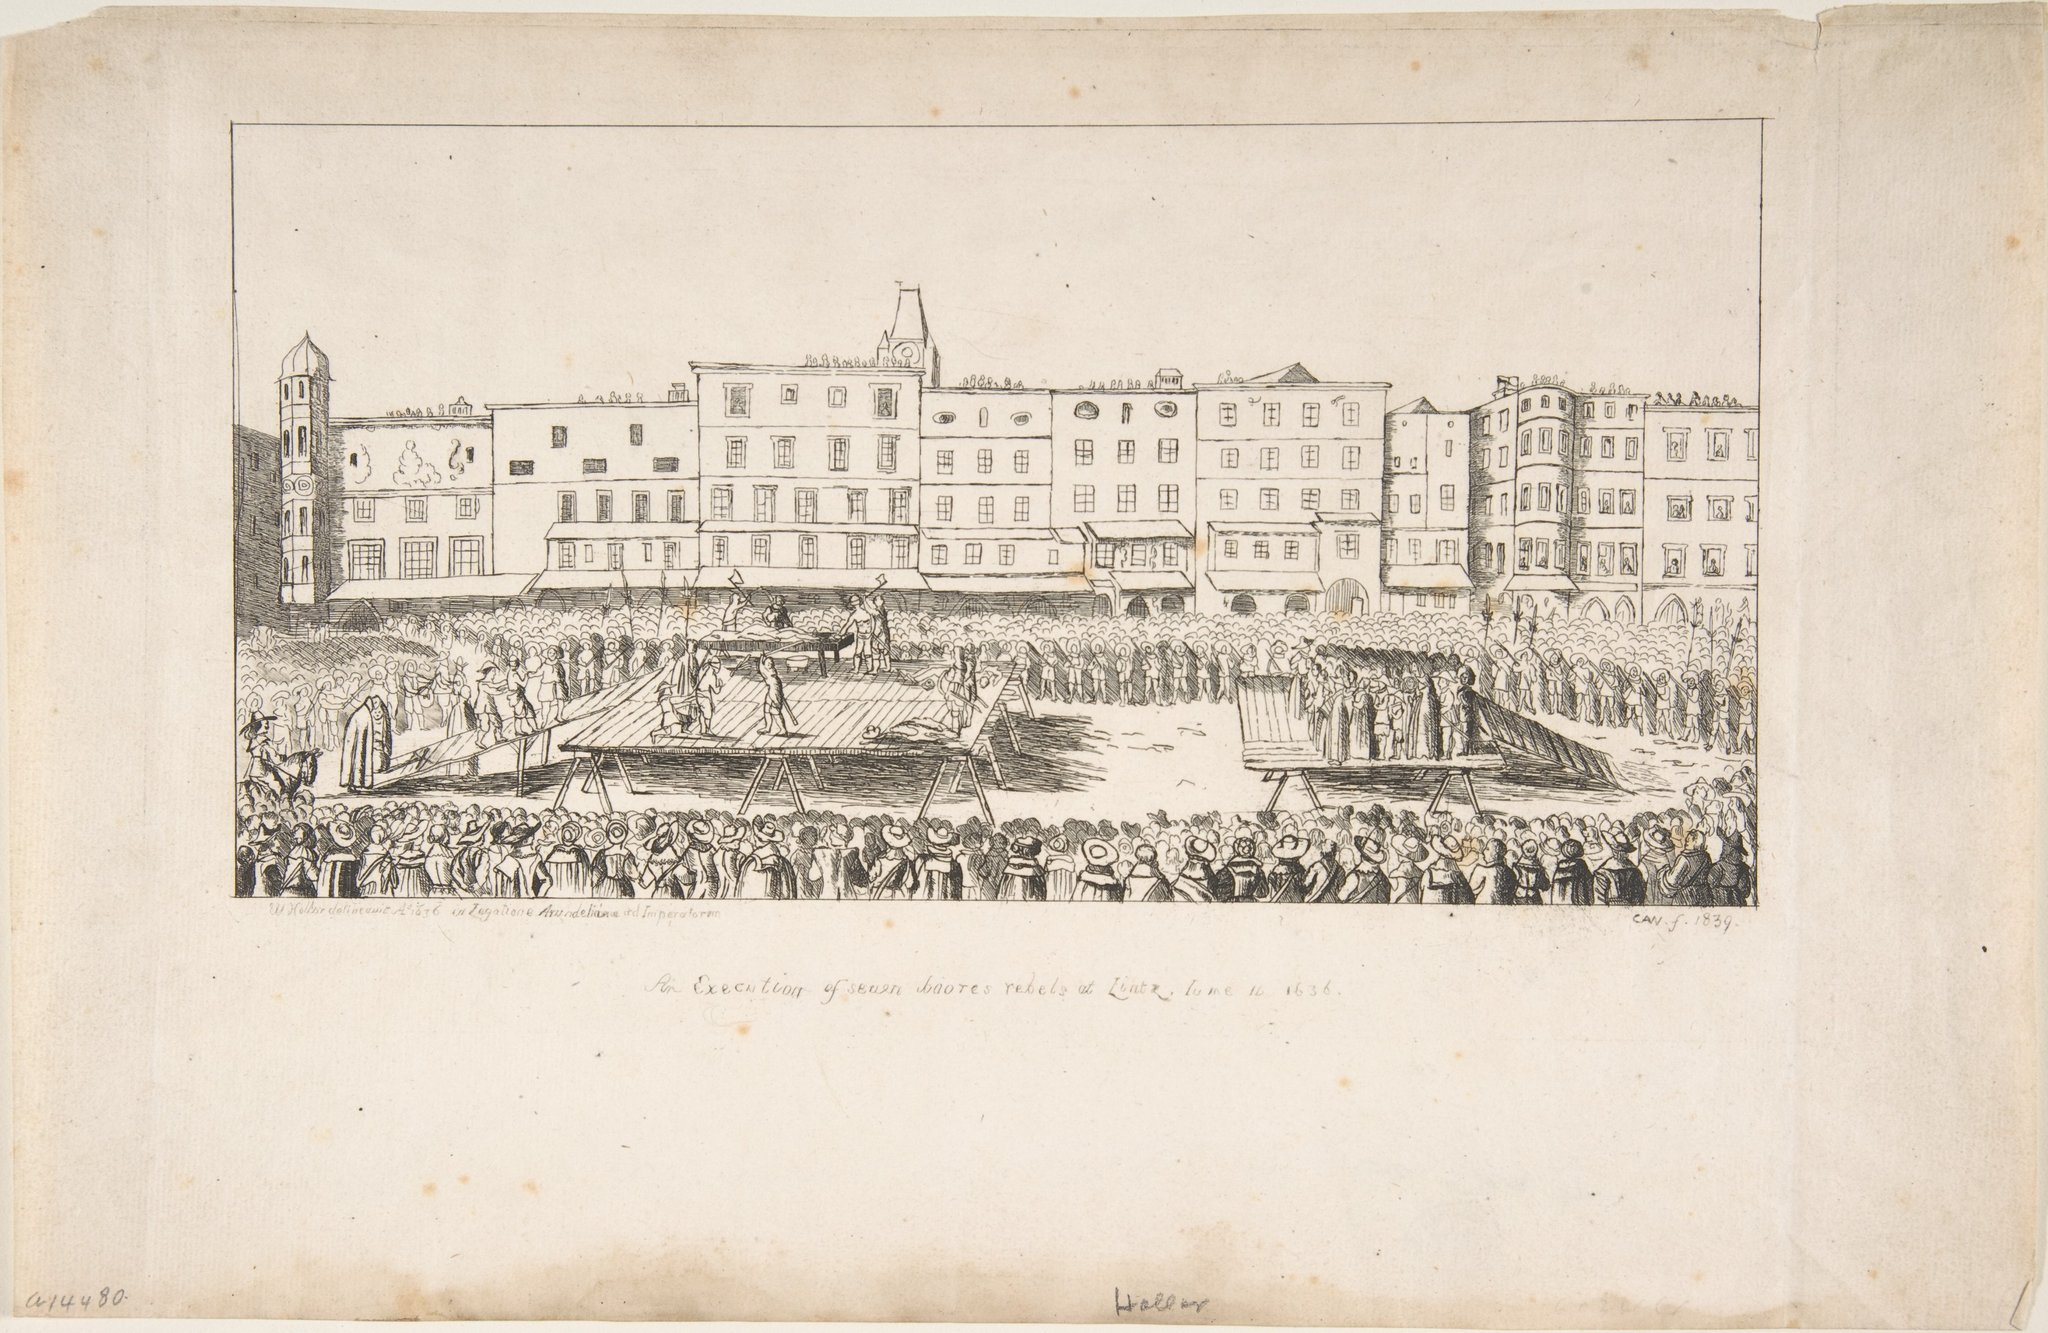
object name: print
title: An Execution of Seven Boores Rebels in Lintz, June 16, 1636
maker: anonymous, british, 19th century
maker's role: artist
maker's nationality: british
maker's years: 1800-1900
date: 1839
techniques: etching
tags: buildings,crowd